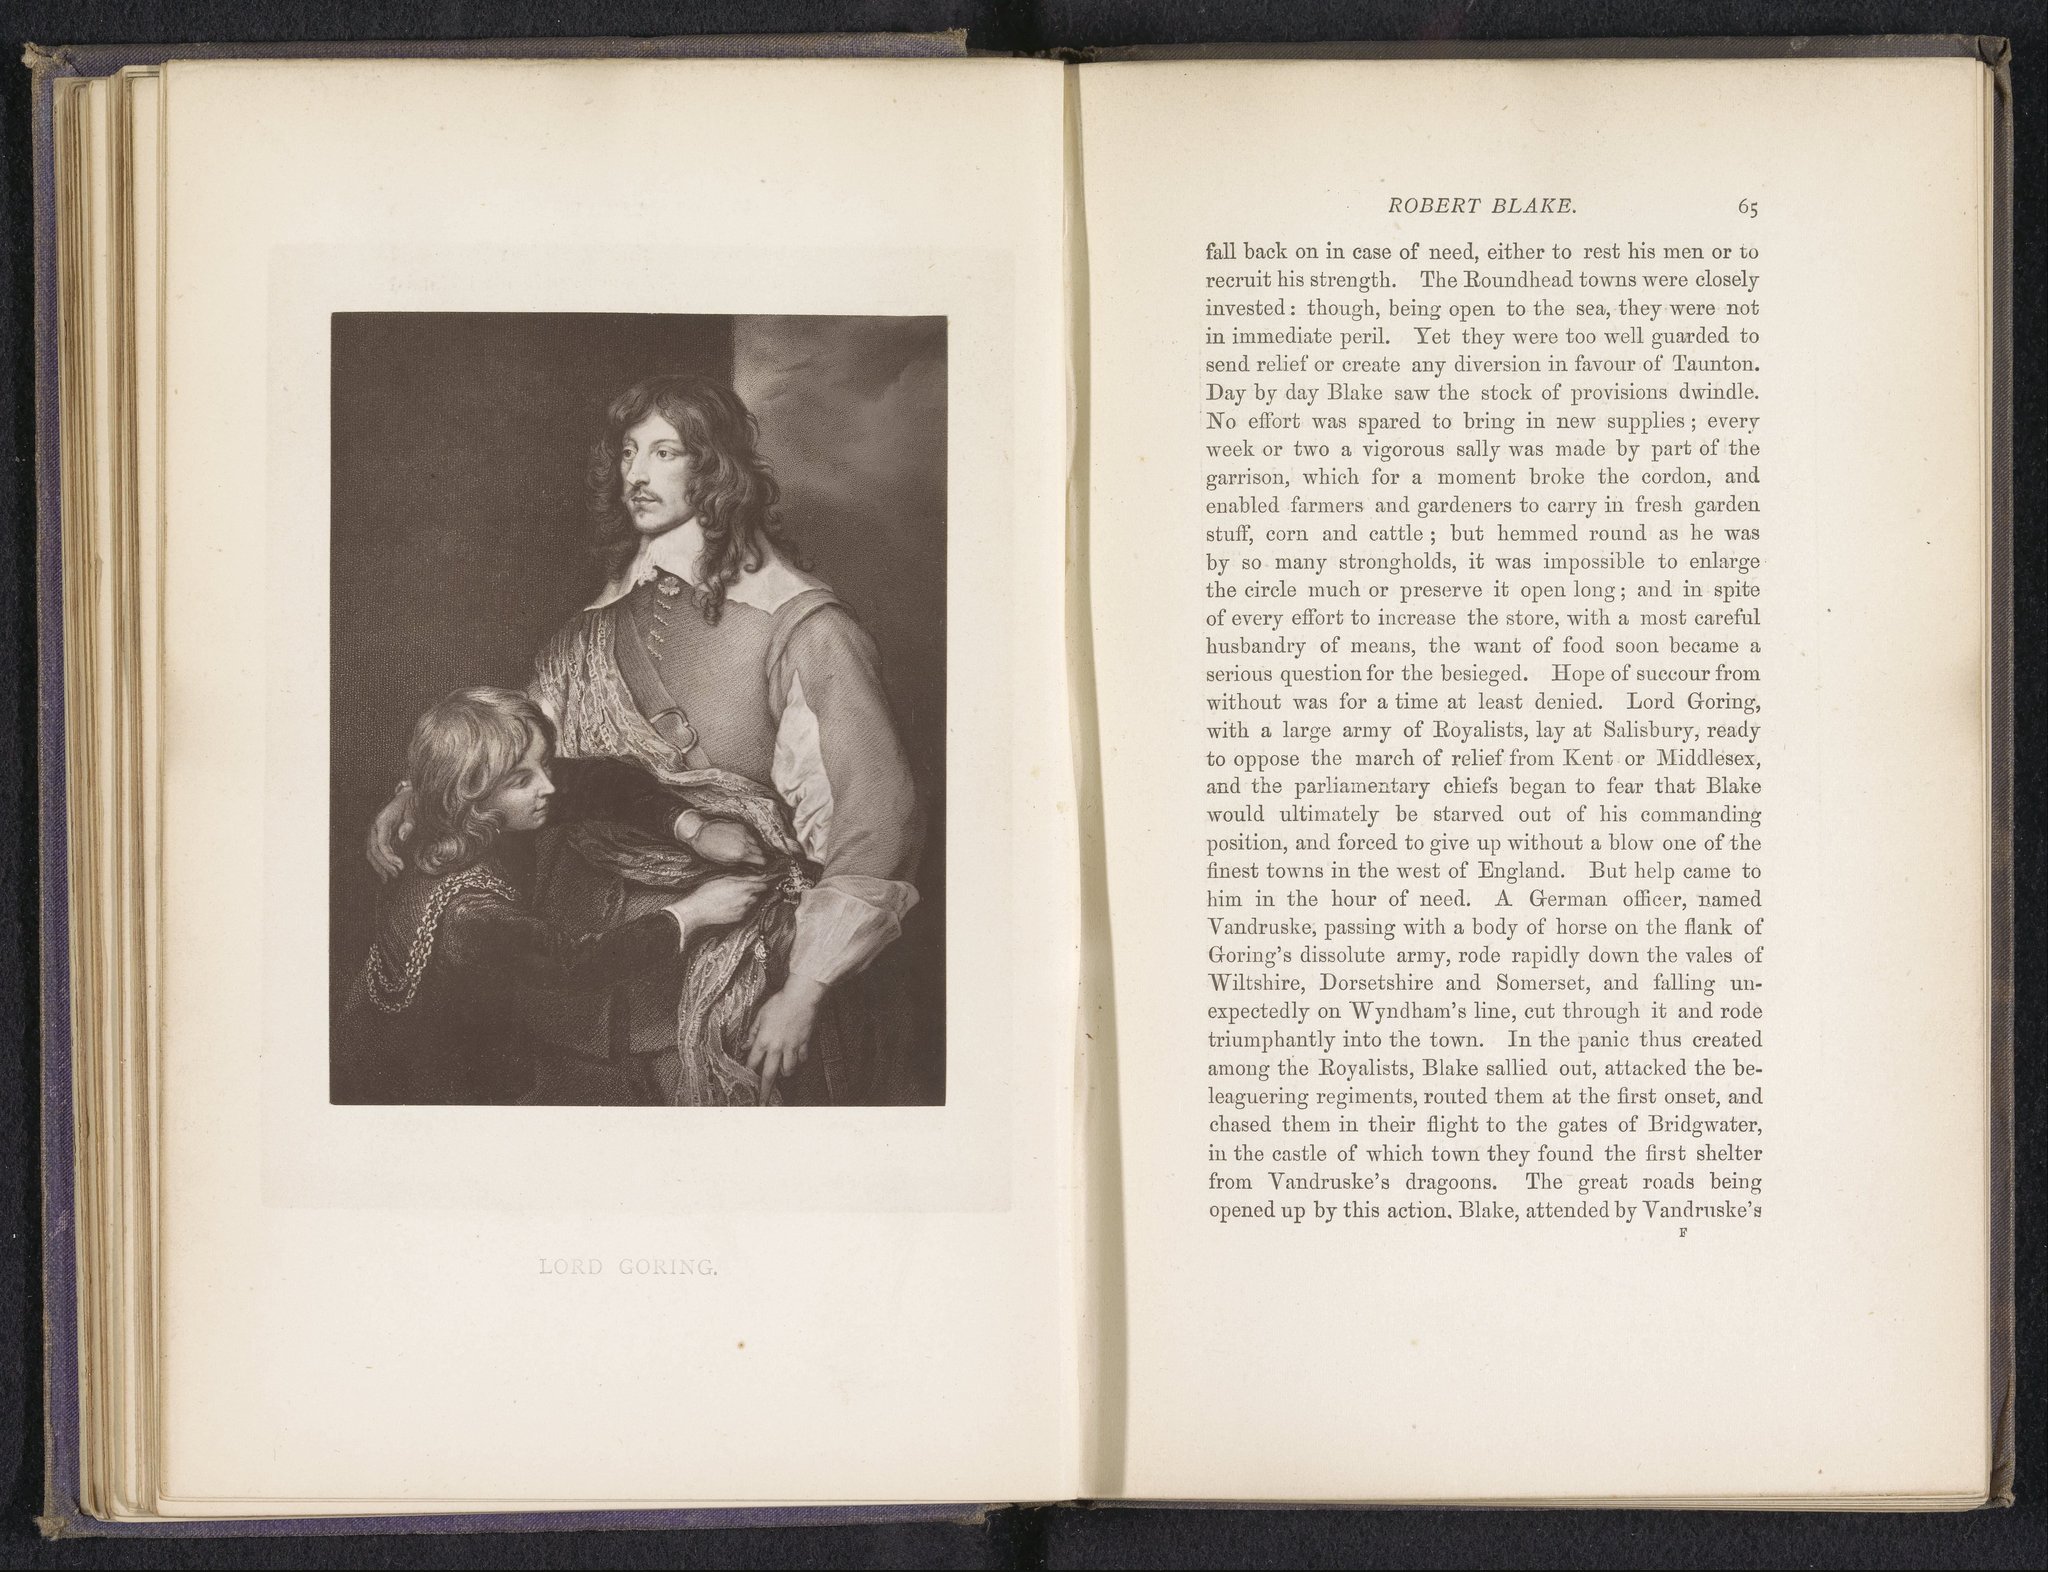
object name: photomechanical print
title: Lord Goring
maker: Anonymous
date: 1875-1885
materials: paper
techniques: woodburytype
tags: private soldier